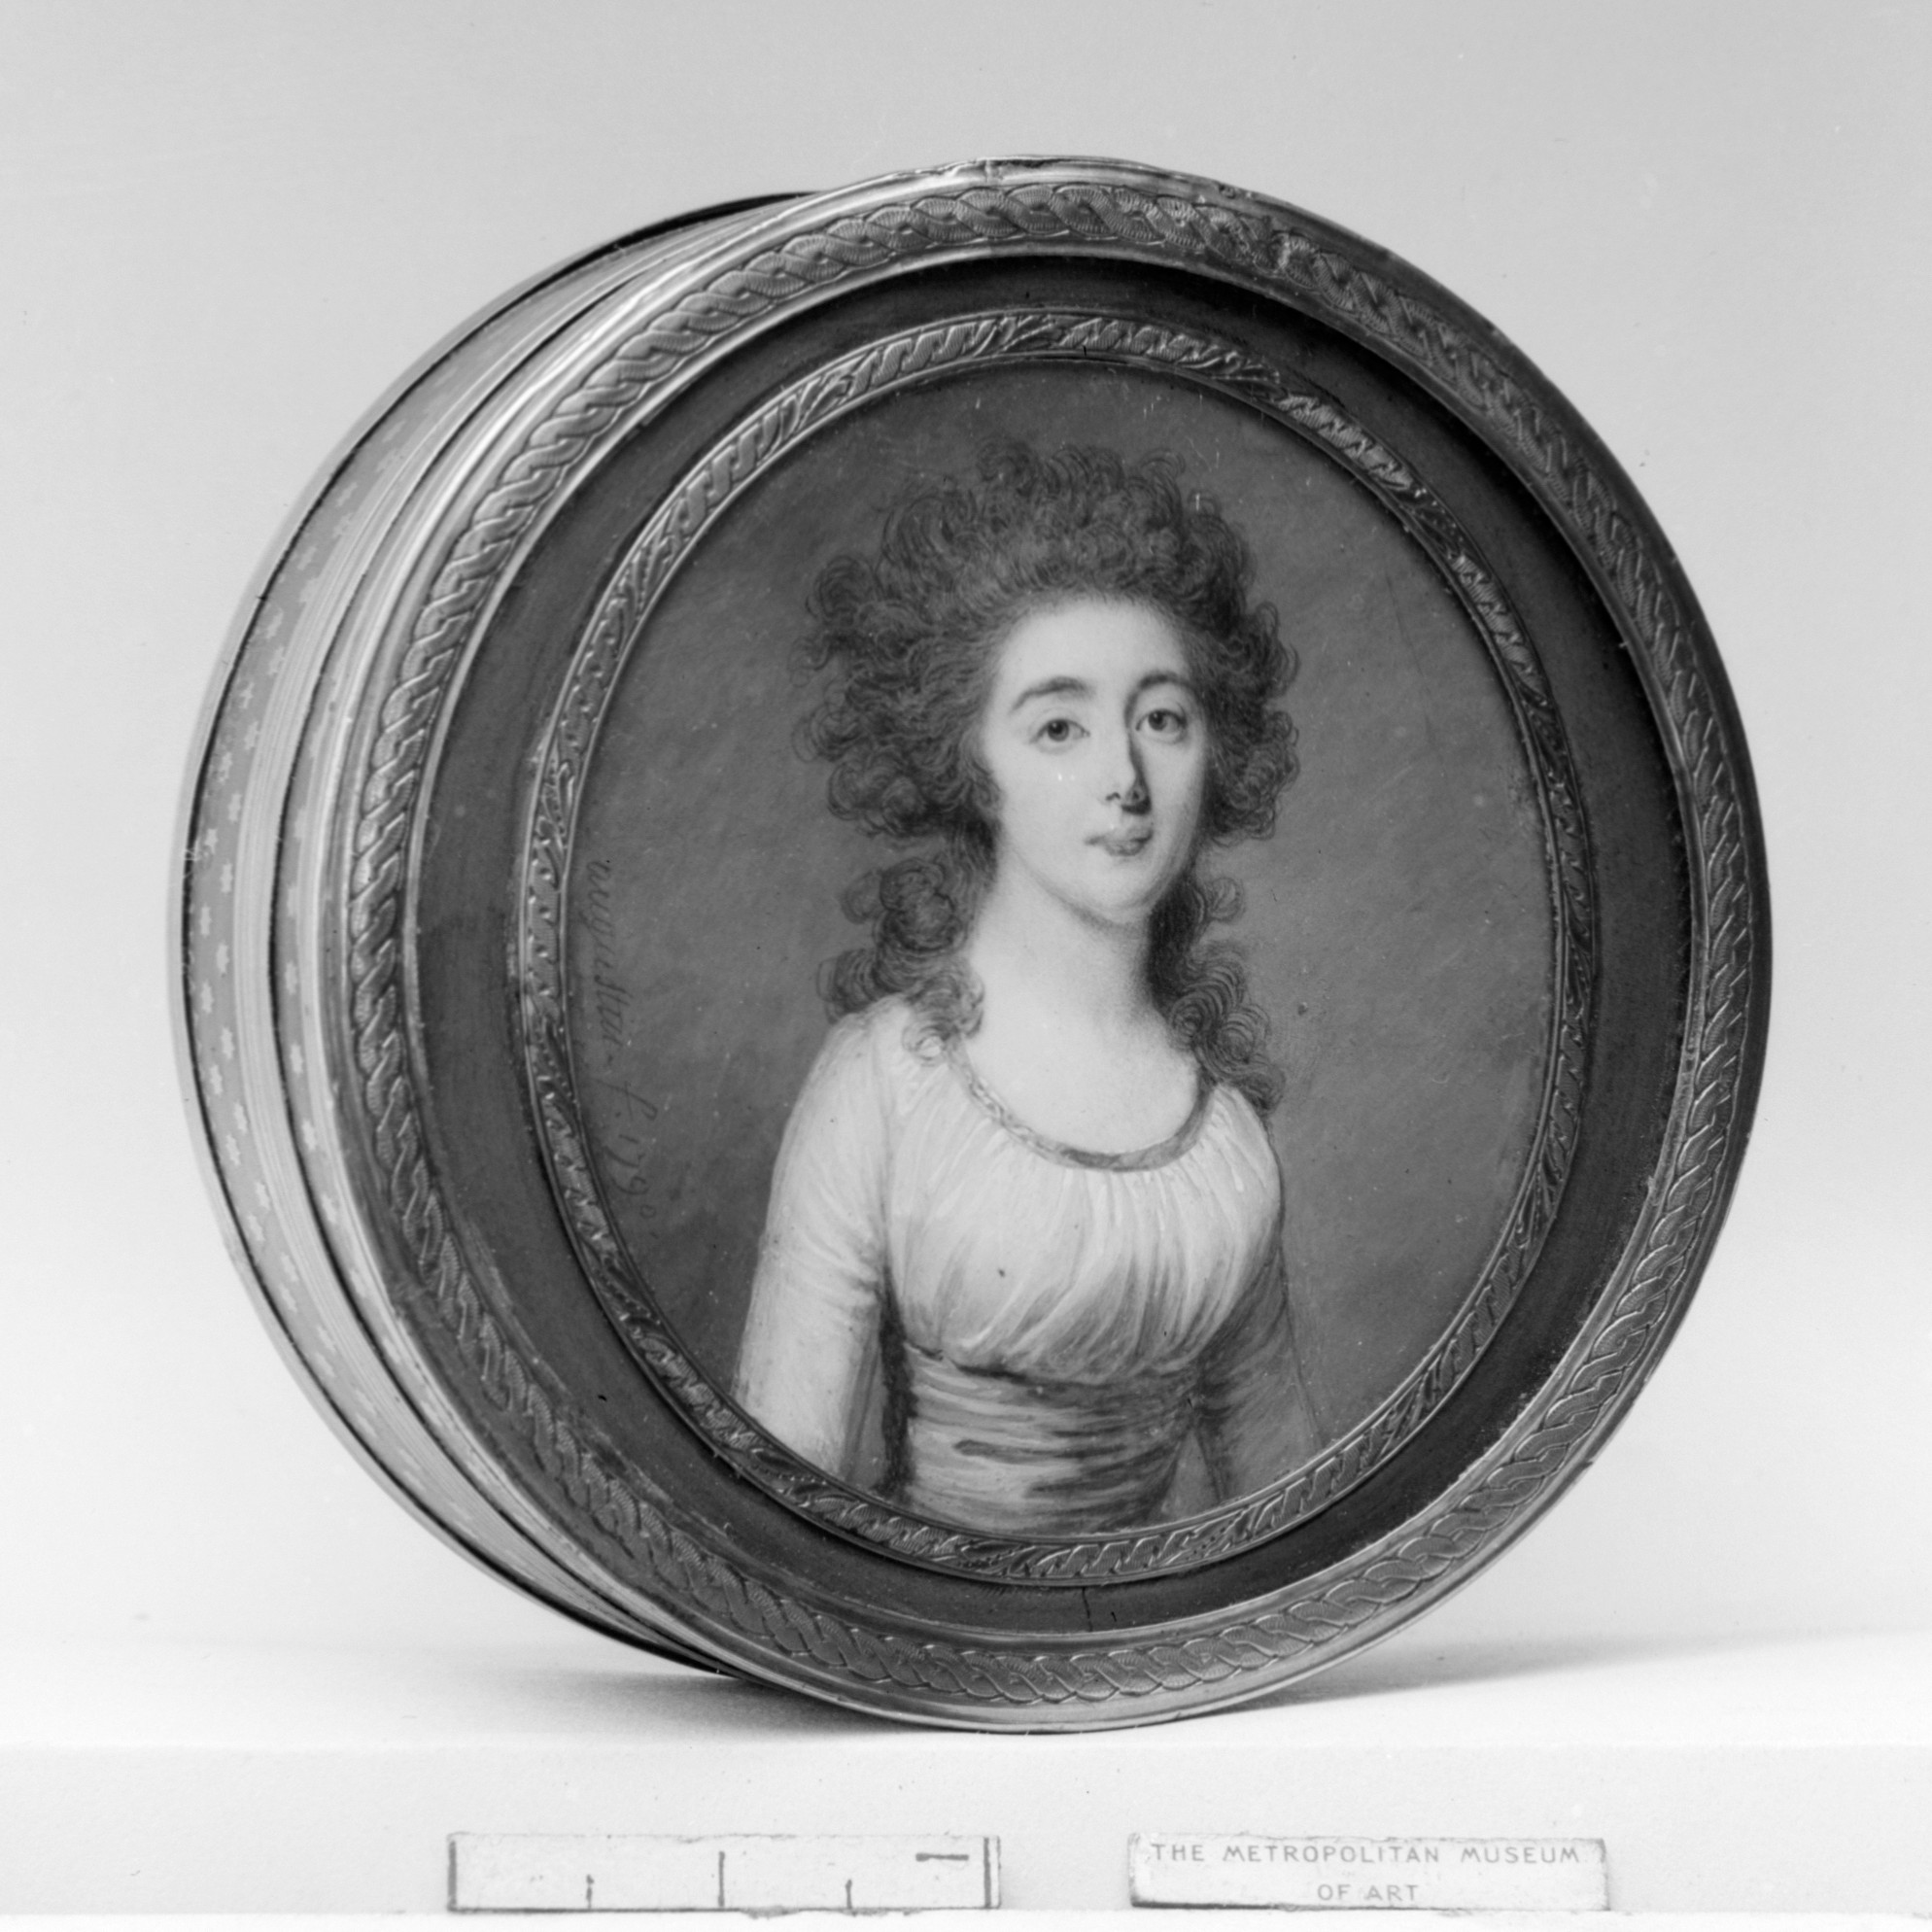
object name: box, painting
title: Box with portrait of a woman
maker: jean-baptiste jacques augustin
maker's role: artist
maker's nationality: french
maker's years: 1759-1832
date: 1775-1781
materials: gold, ivory, shell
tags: portraits,women